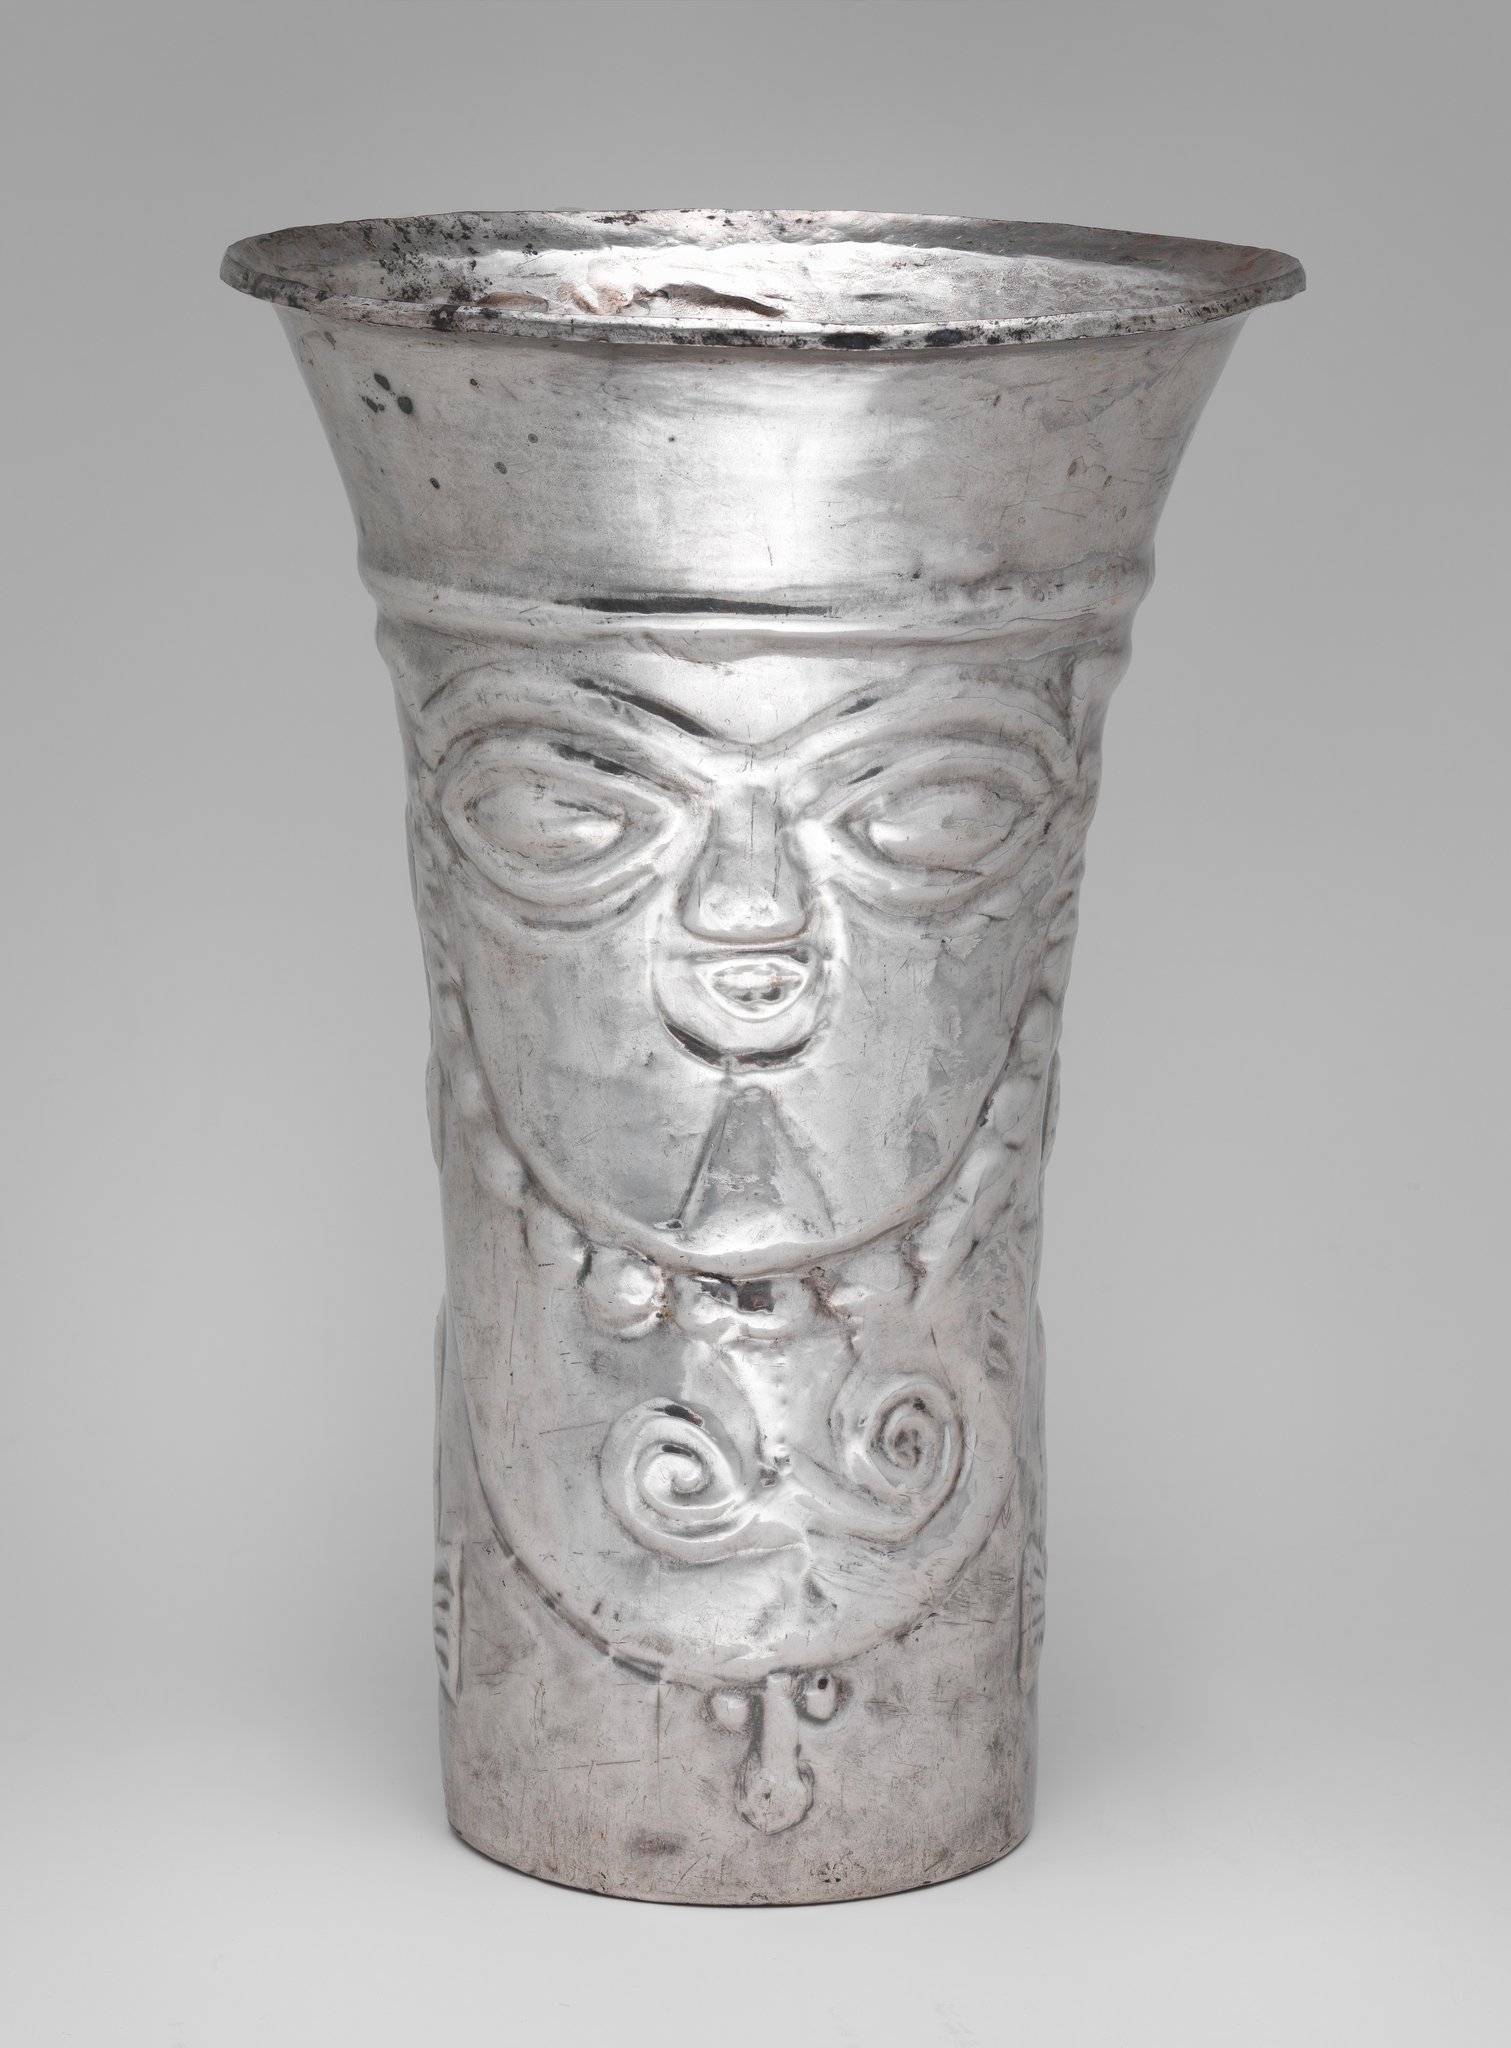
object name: beaker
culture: chimú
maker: chimú artist(s)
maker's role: artist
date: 1100-1470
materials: silver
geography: peru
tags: faces